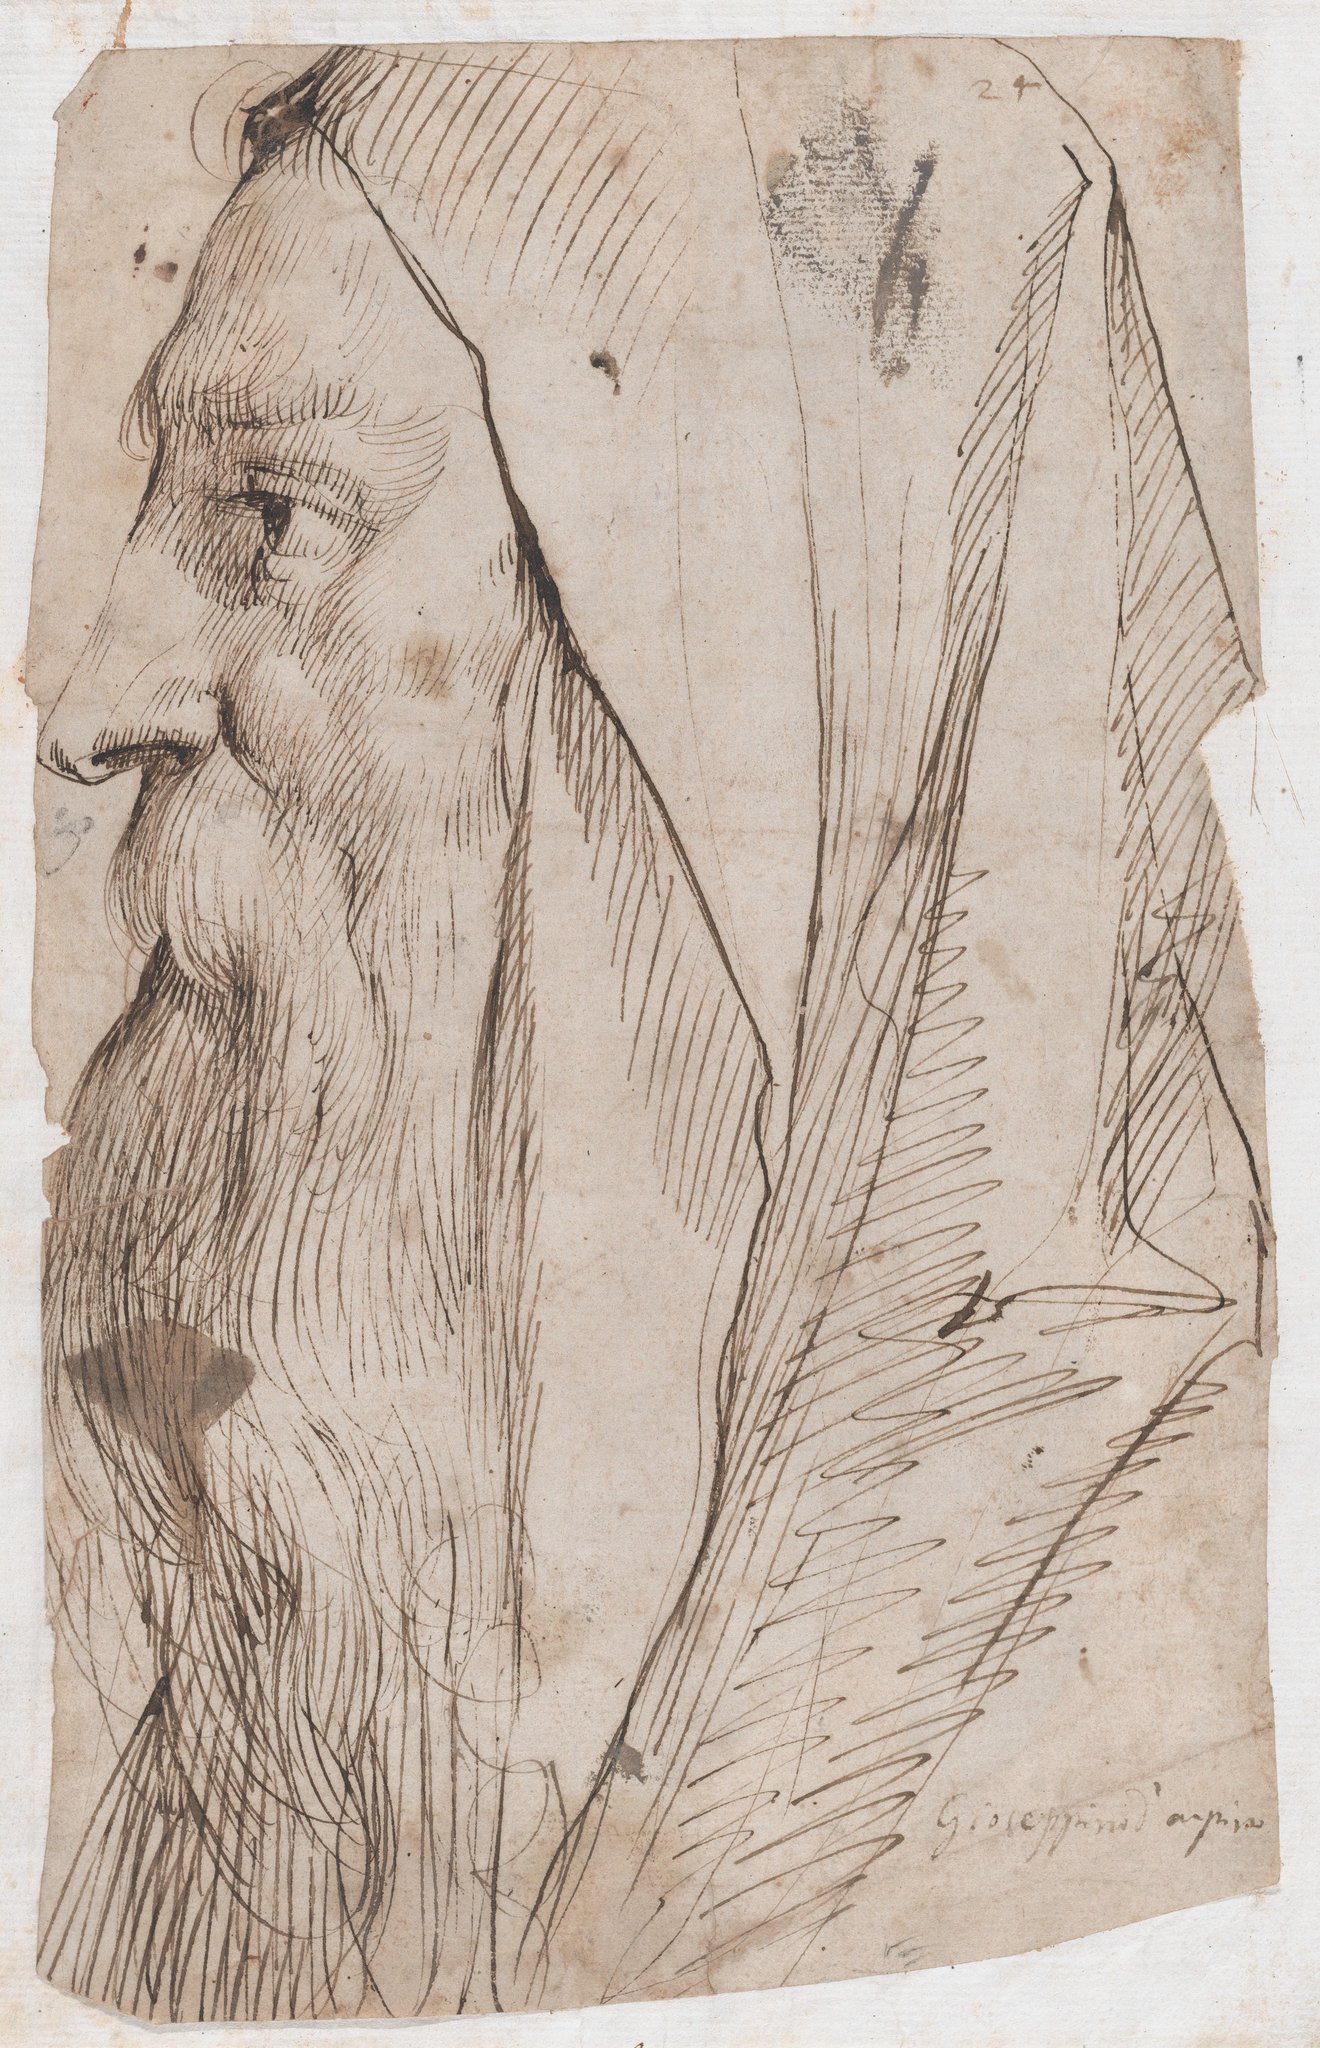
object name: drawing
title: Head of a Bearded Man Wearing a Hood in Profile Facing Left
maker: cavaliere d'arpino (giuseppe cesari)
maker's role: artist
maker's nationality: italian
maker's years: 1568-1640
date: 1636-1638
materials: ink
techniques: pen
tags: men,profiles